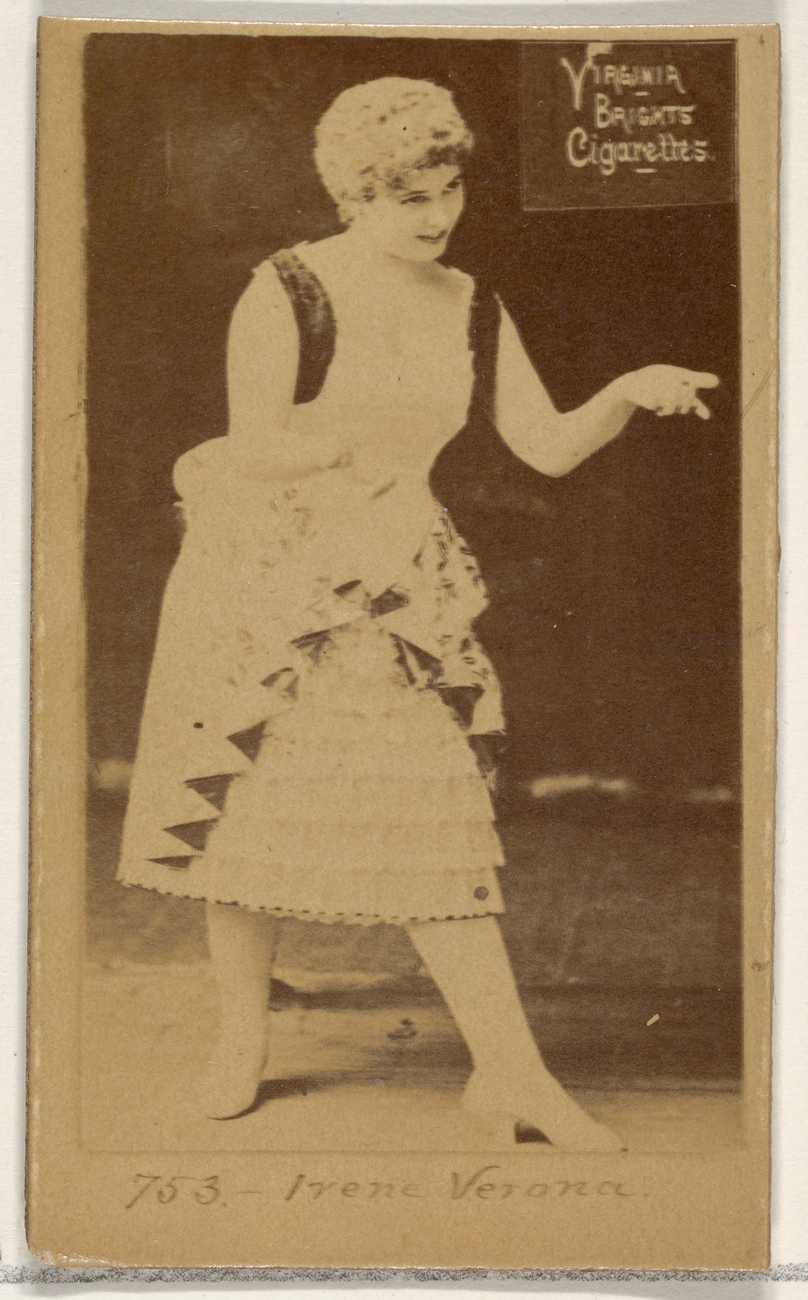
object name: photograph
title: Card 753, Irene Verona, from the Actors and Actresses series (N45, Type 2) for Virginia Brights Cigarettes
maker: allen & ginter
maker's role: publisher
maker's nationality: american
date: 1888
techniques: albumen silver print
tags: portraits,women,actresses